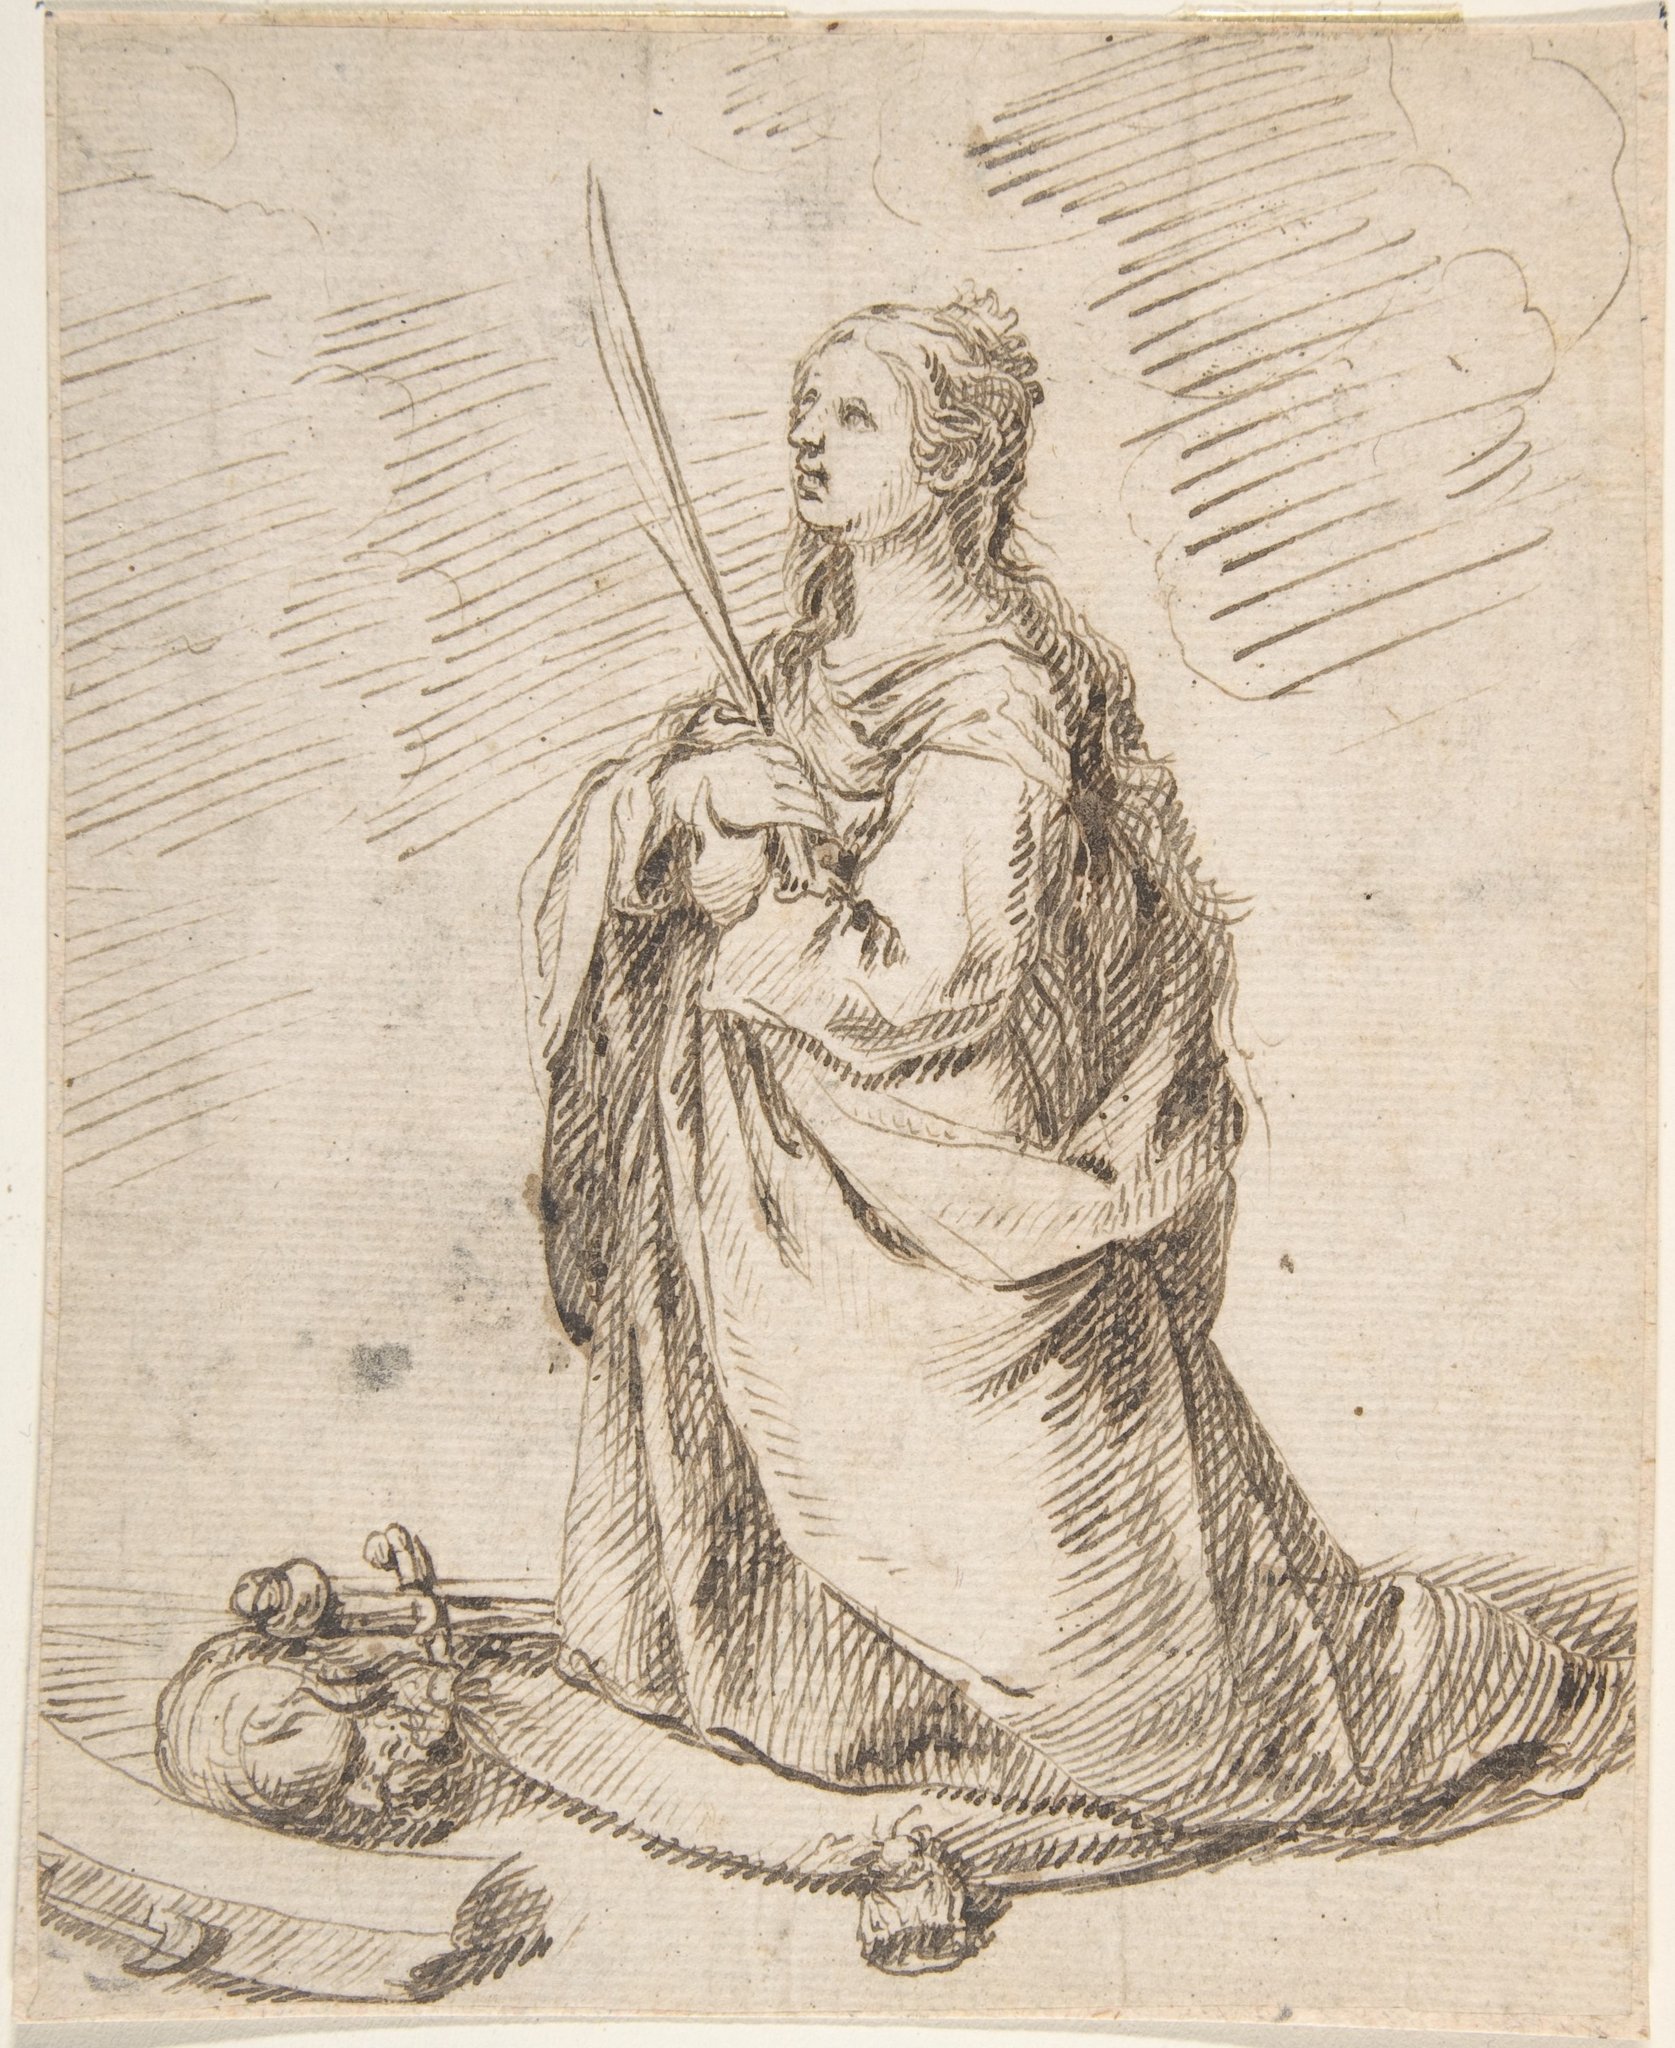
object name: drawing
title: Kneeling Figure of Saint Catherine of Alexandria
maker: anonymous, spanish, school of seville, 17th century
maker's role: artist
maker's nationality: spanish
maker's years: 1600-1700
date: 1601-1700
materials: ink, paper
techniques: pen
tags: saint catherine